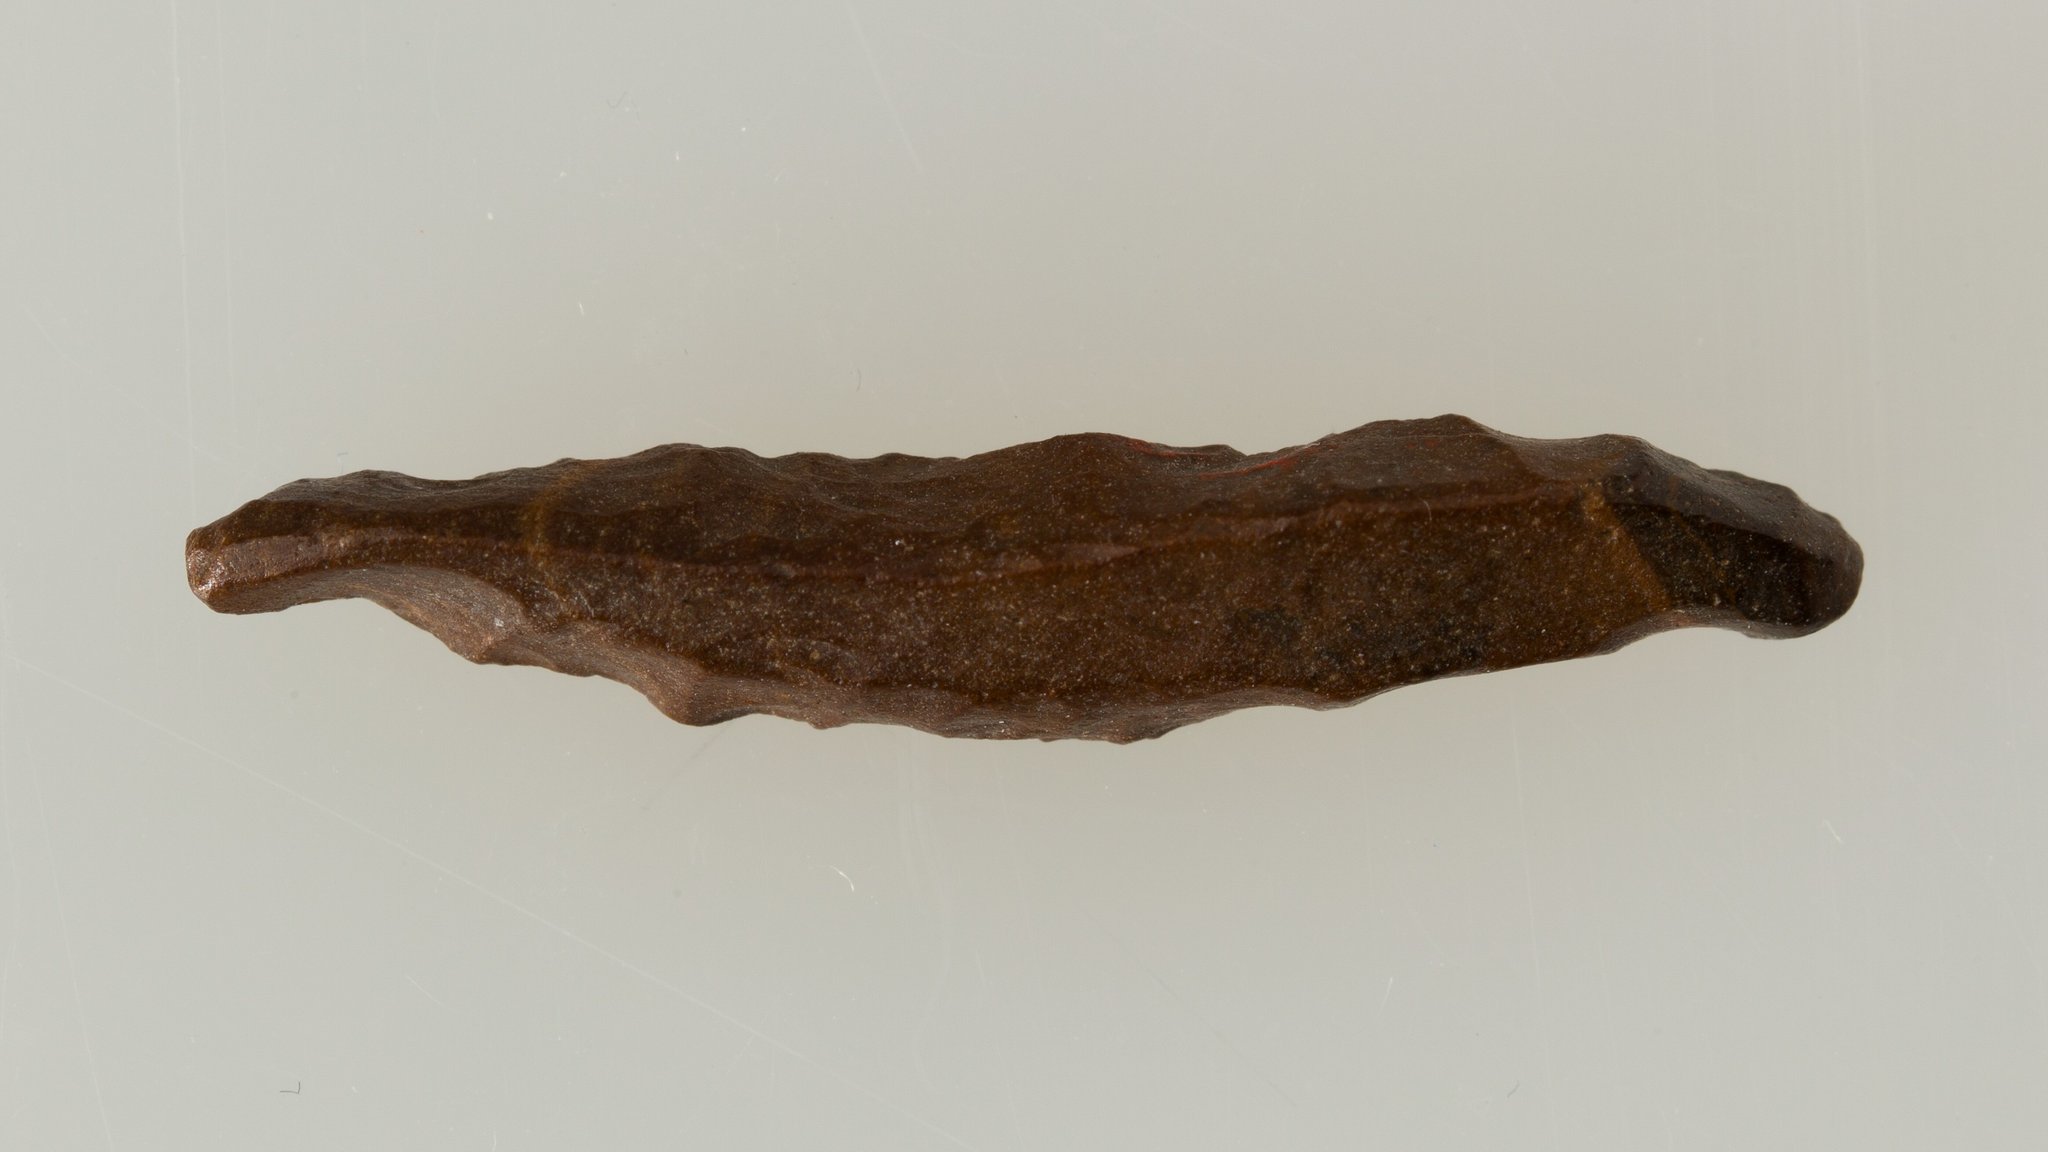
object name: tool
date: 3850-2960 BCE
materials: stone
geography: egypt